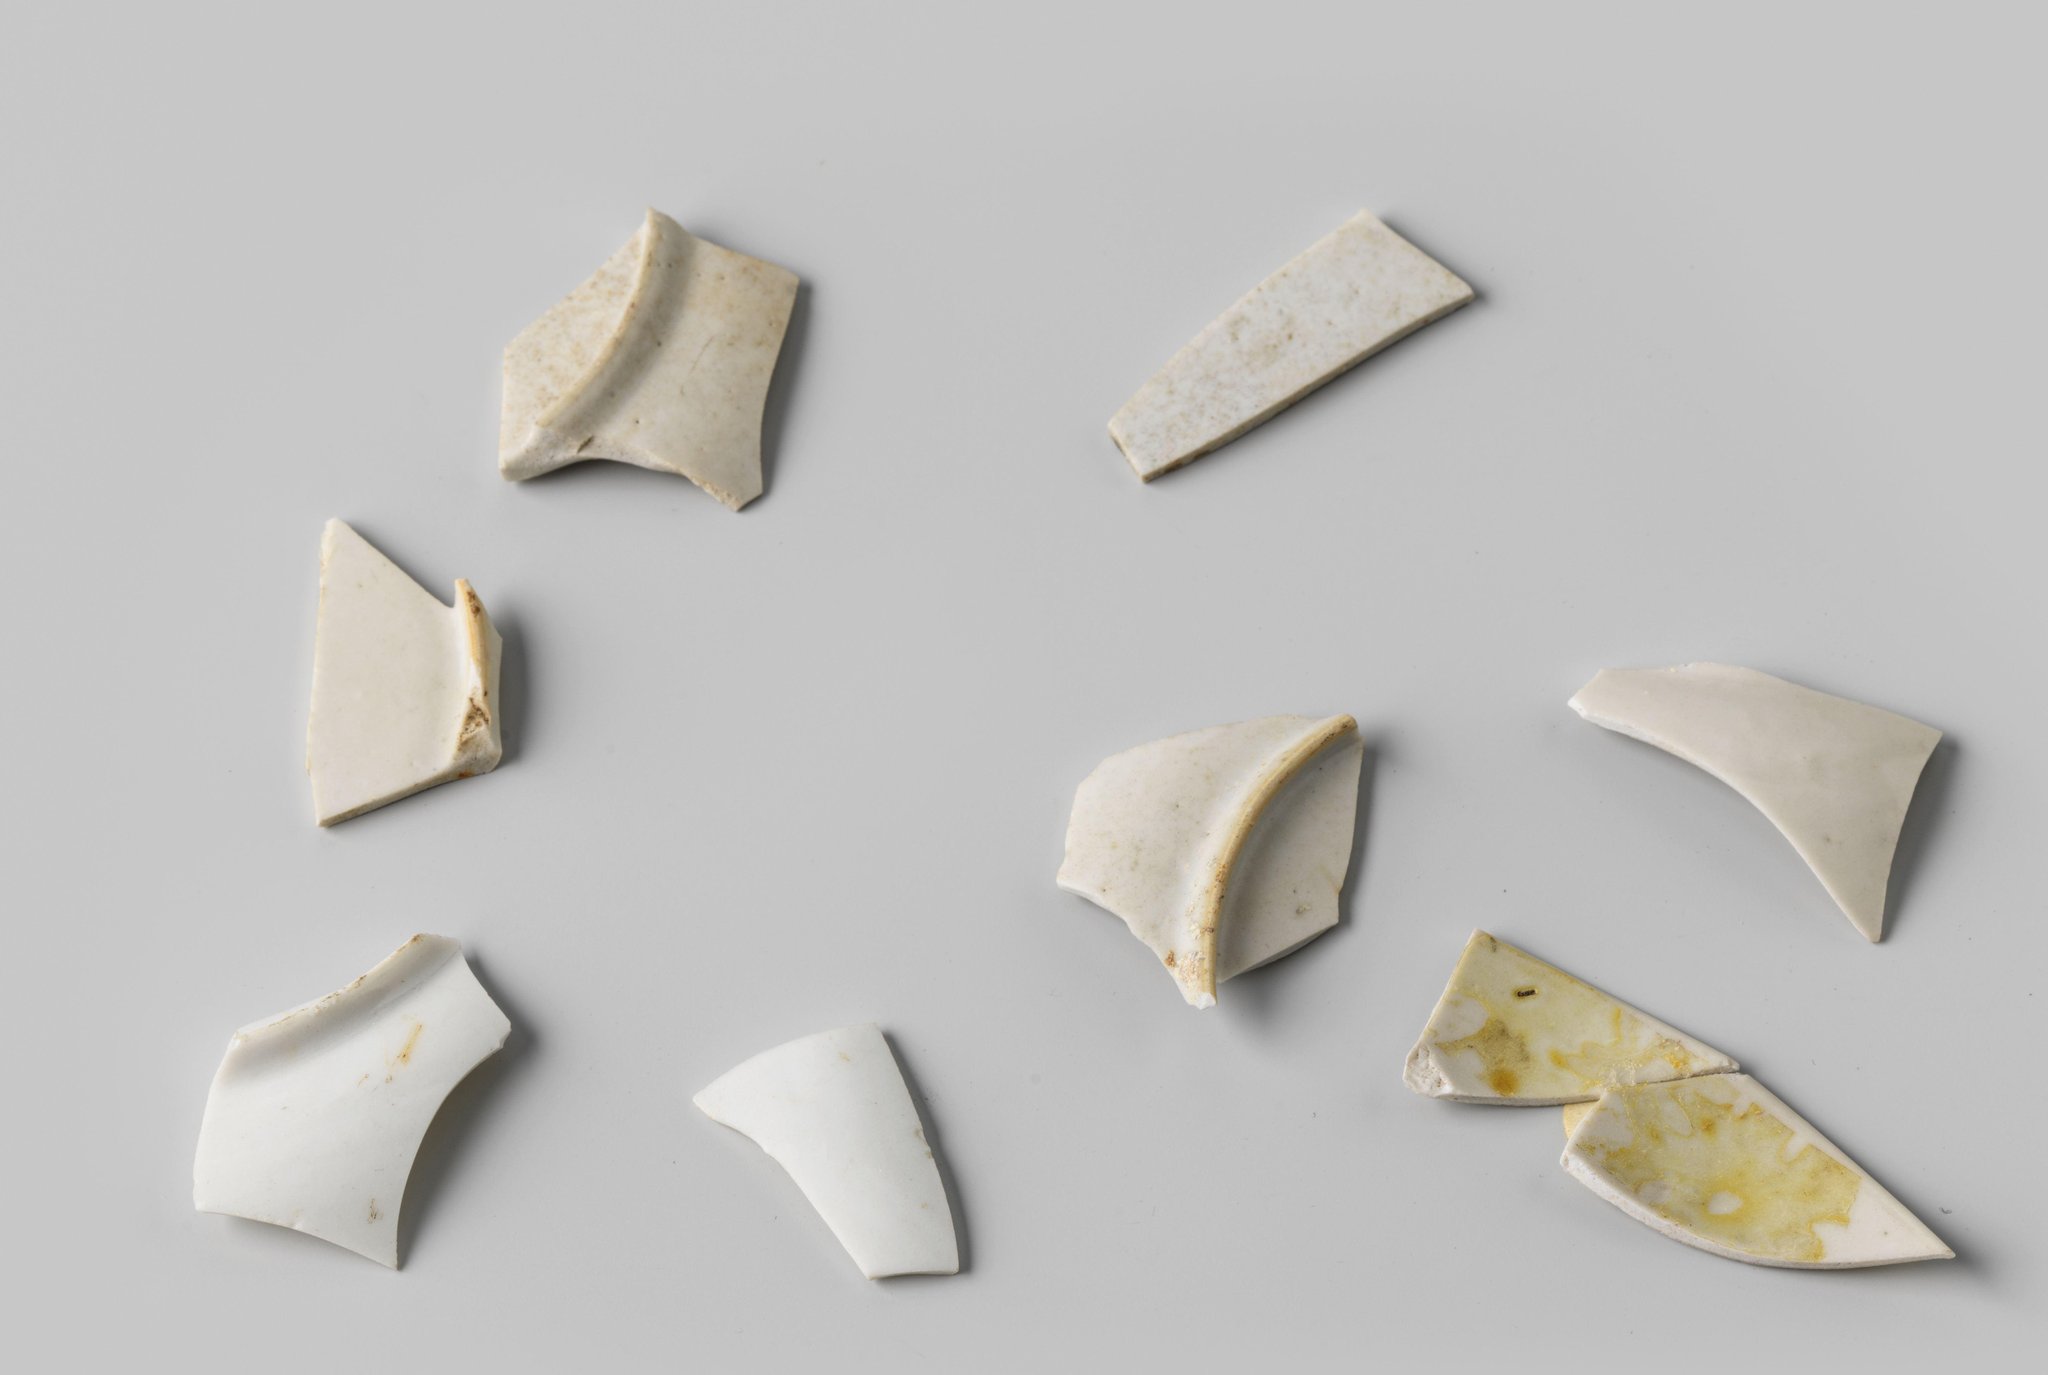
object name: platter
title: Acht scherven van één of verschillende schotels, gevonden bij V.O.C.-schip Witte Leeuw, mogelijk afkomstig van Zeelelie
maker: Anonymous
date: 1775-1800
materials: porcelain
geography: china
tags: verenigde oostindische compagnie, sint-helena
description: Acht scherven van één of verschillende schotels, waarvan één uit twee aan elkaar gelijmde fragmenten, gevonden bij V.O.C.-schip de 'Witte Leeuw'. Dit object is 18e-eeuws en kan dus niet van de vracht van de Witte Leeuw zijn. Onduidelijk is of het object van de site komt of dat het later is vermengd, mogelijk met materiaal van de Zeelelie.